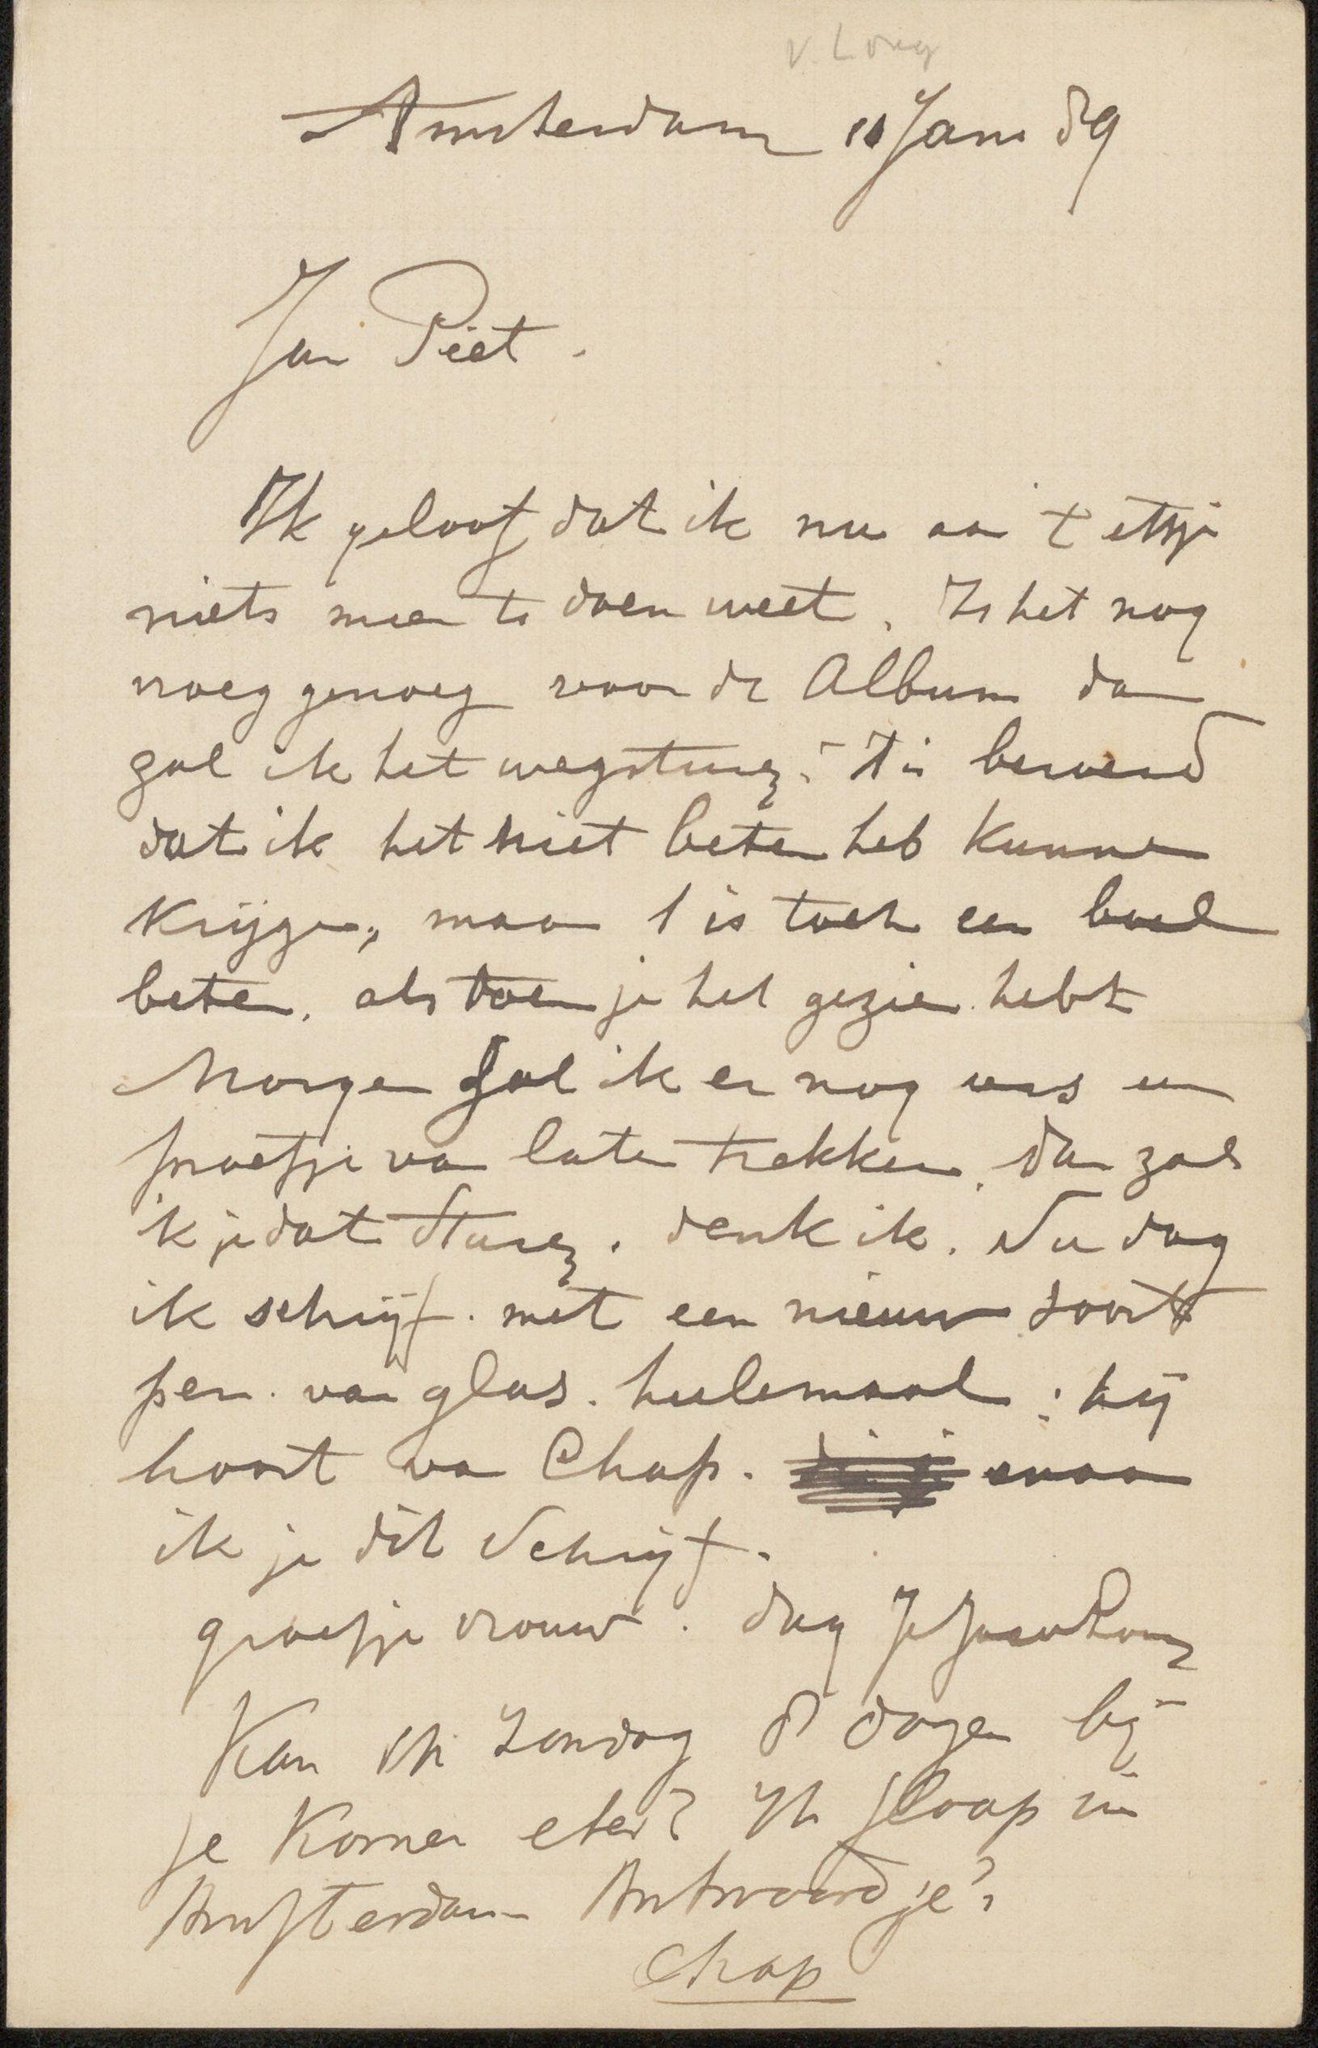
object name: letter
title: Brief aan Jan Veth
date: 1889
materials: ink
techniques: pen, writing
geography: amsterdam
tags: dordrecht, amsterdam, designer, jan veth, the graphic arts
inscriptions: collector's mark: ‘RPK’